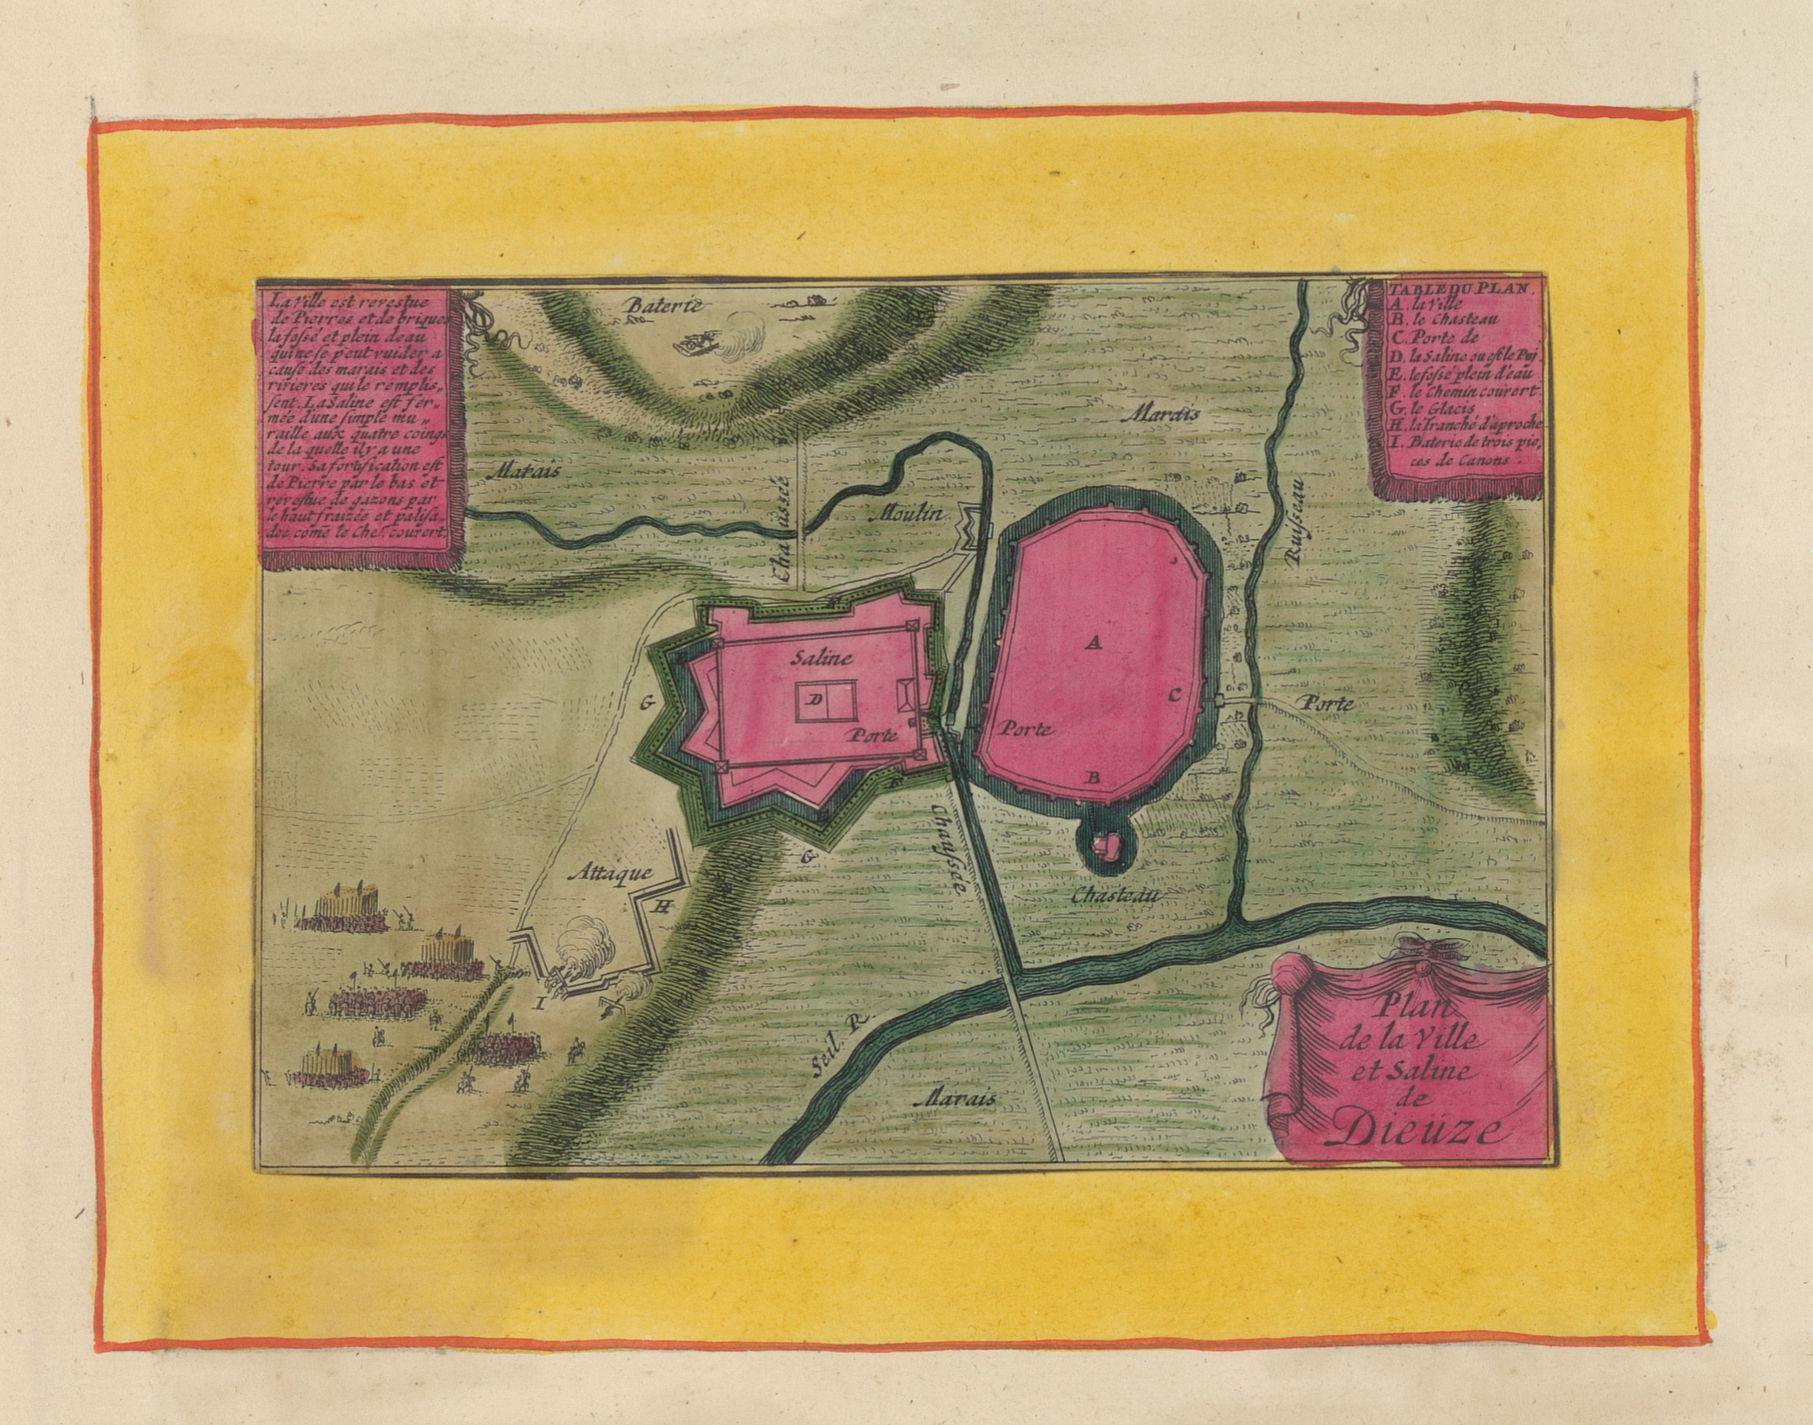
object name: area plan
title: Plan de la ville et saline de Dieuze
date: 1700-1702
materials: paper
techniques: engraving, hand coloring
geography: amsterdam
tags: maps of cities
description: Deze plattegrond is in meerdere atlassen gebruikt. Onder andere in: Les forces de l'Europe. 10 dln. Amsterdam: Pieter Mortier, ca. 1700. En in: Les forces de l'Europe. 12 dln. Amsterdam: Pieter Mortier, 1702. Door het ontbreken van de marges van deze prent is onduidelijk om welke staat het gaat. Derhalve is niet te bepalen uit welke van deze publicaties dit exemplaar komt. Later is deze zelfde prent door Pieter van der Aa gebruikt in twee publicaties. Gezien het eind van de werkzame periode van de inkleurder van de prenten in dit album is het niet mogelijk dat deze prent uit een van die publicaties komt.